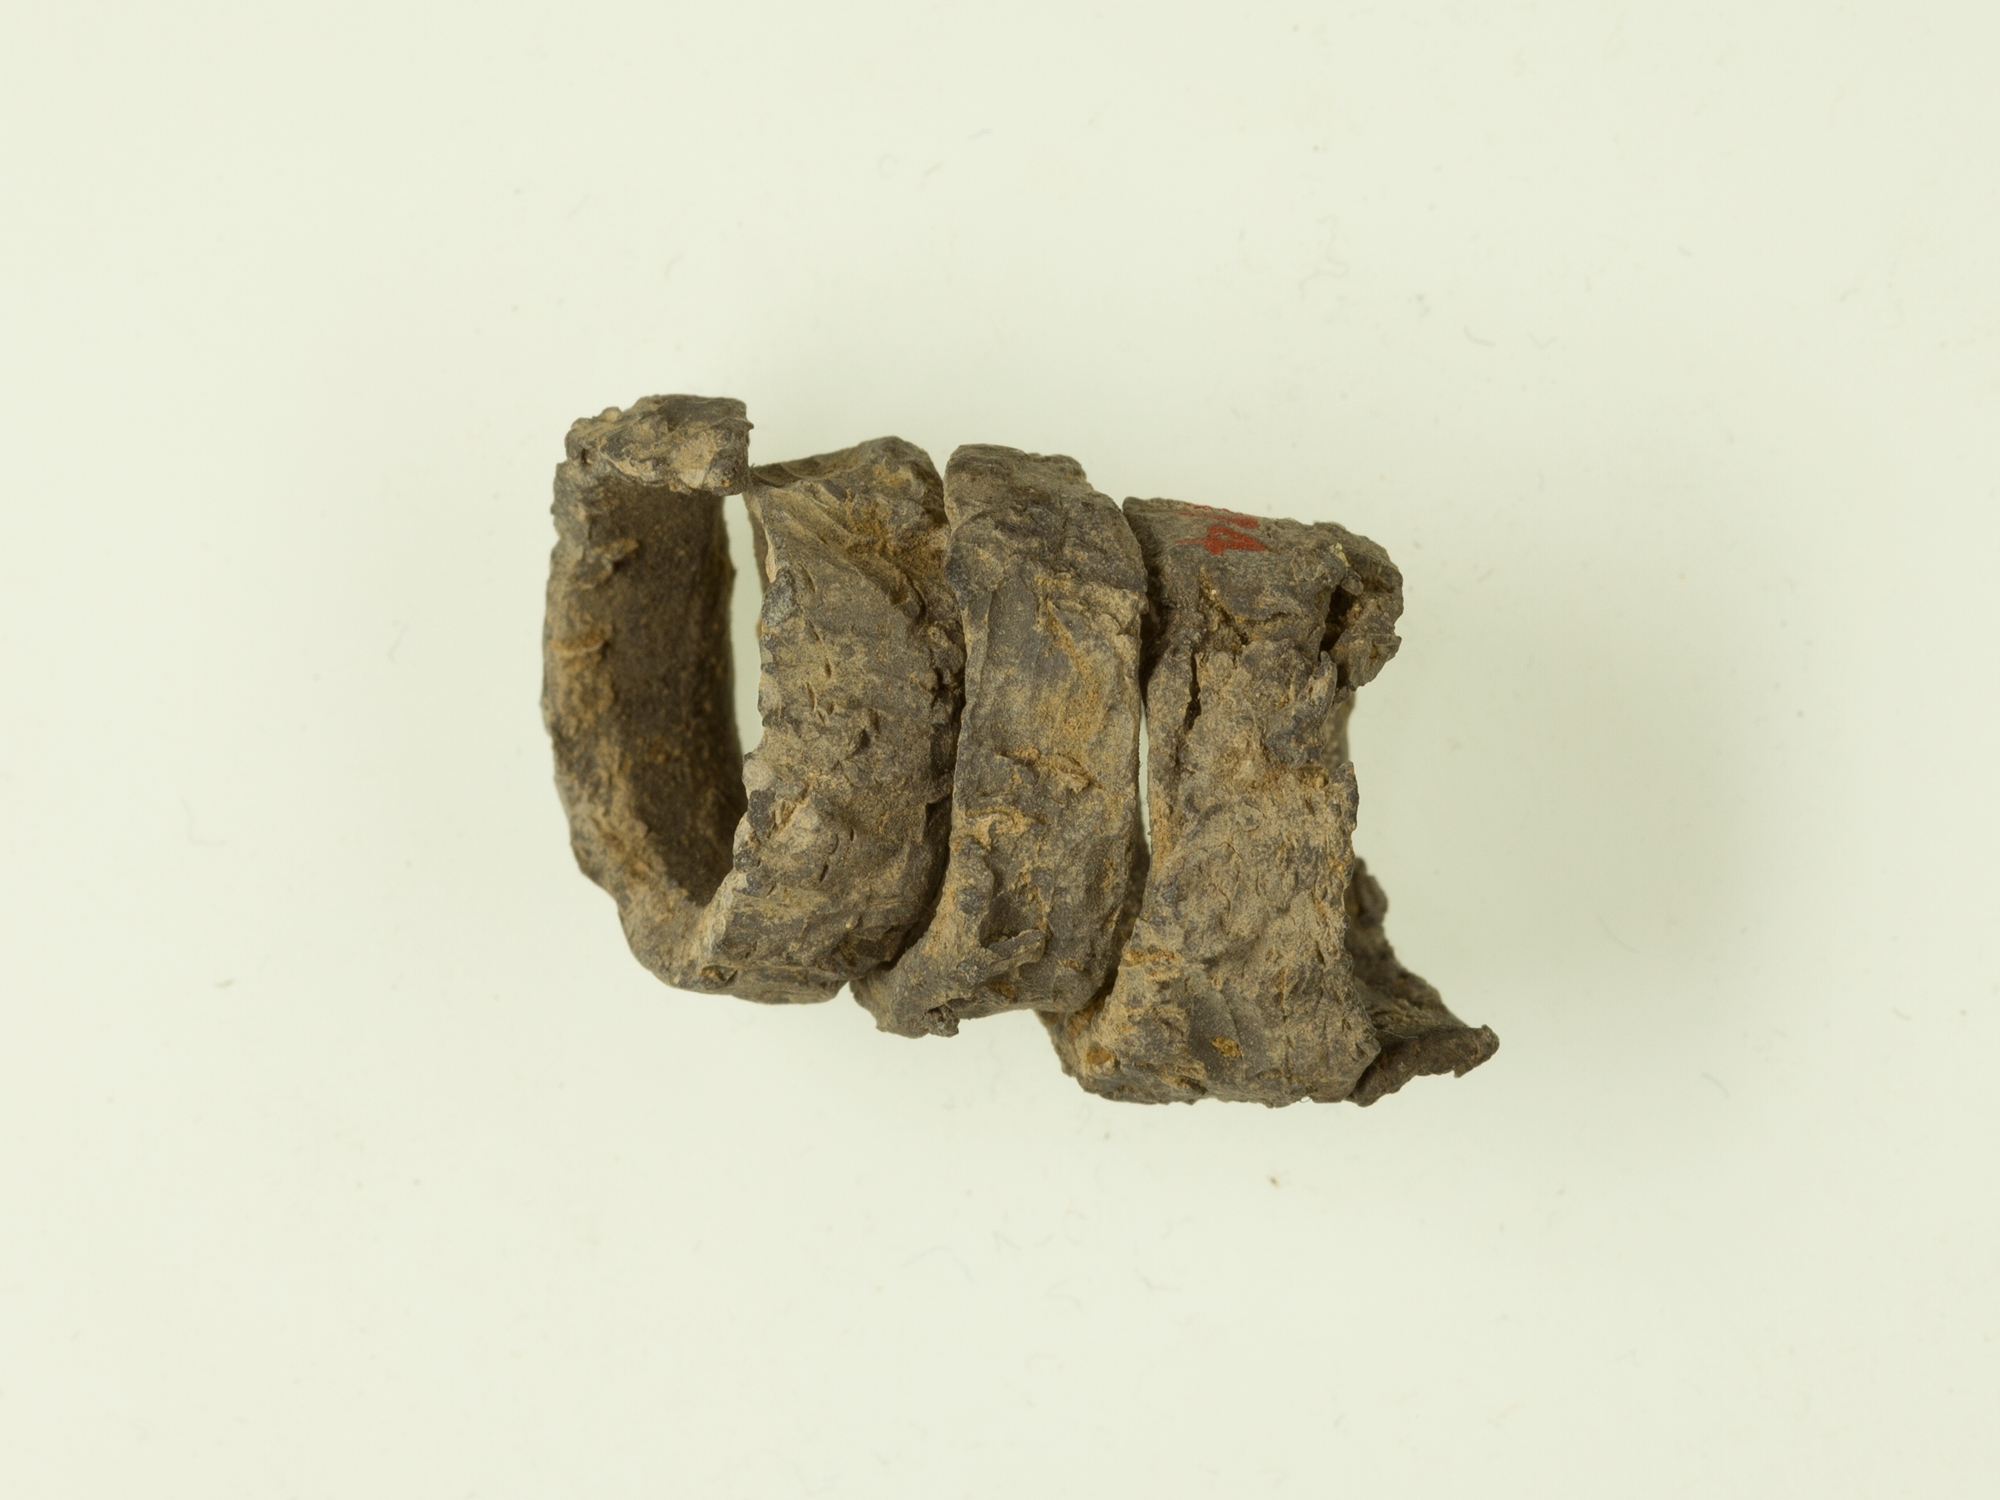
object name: household ring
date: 1295-1070 BCE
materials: bronze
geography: egypt